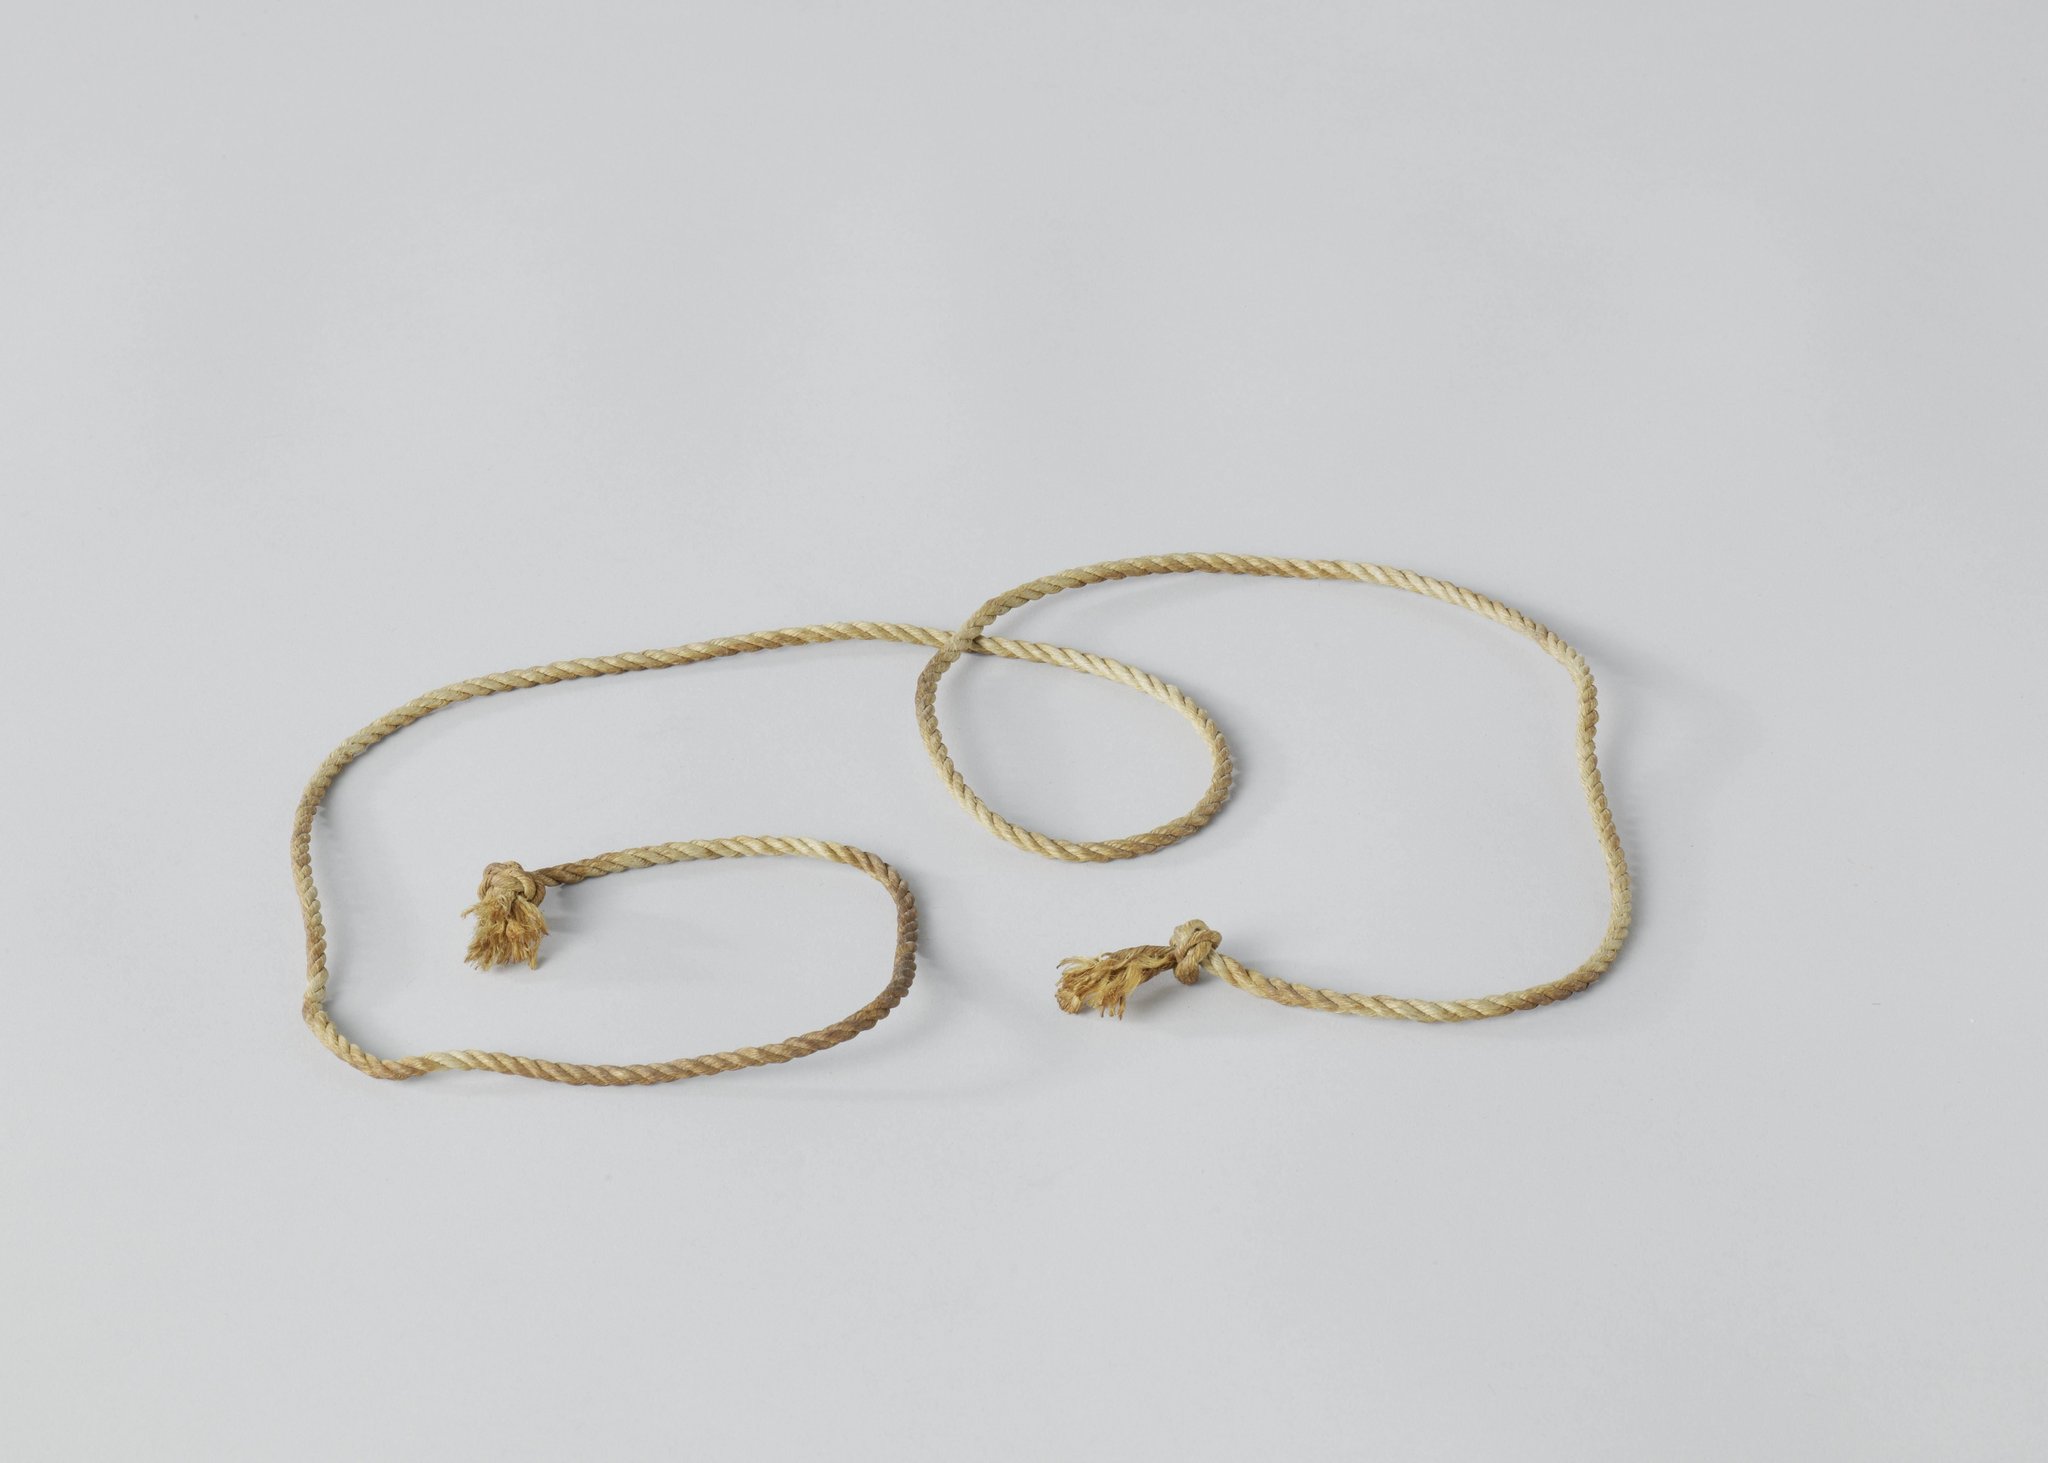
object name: sample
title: Sample of a Deep-Sea Lead Line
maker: Anonymous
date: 1857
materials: fiber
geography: netherlands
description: Monster van een diepzee loodlijn. Het is een stuk driestrengs kabelslag touw met een knoop aan ieder eind. De strengen zijn ook kabelslag gelegd. Het gewicht van deze loodlijn was 0.89 Nederlandse pond voor iedere 100 m; de breekkracht was 140 Nederlandse ponden.